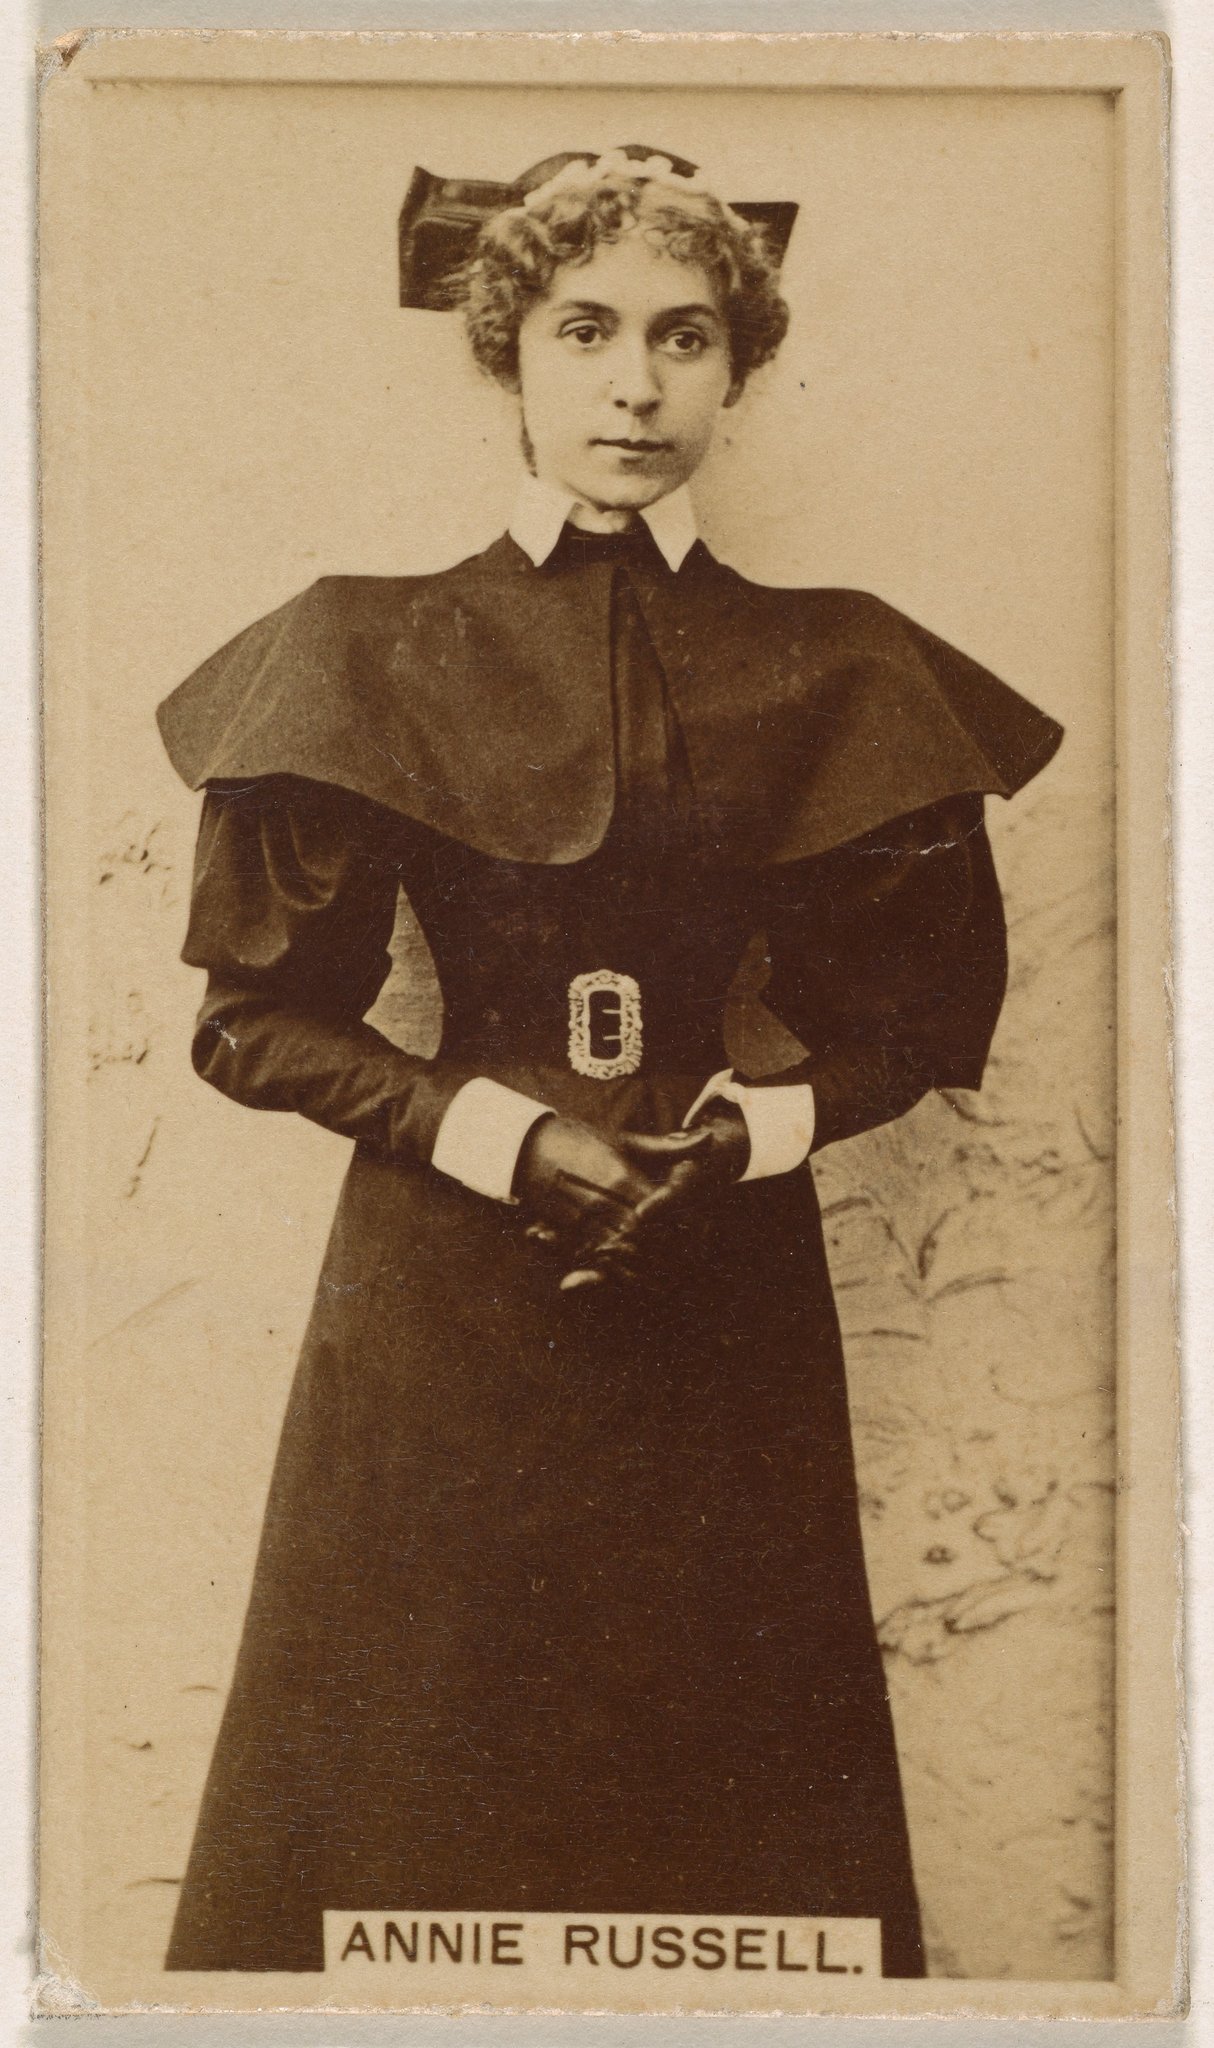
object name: photograph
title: Annie Russell, from the Actresses series (N245) issued by Kinney Brothers to promote Sweet Caporal Cigarettes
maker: kinney brothers tobacco company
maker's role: publisher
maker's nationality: american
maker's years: 1869-2011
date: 1890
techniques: albumen silver print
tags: portraits,women,actresses